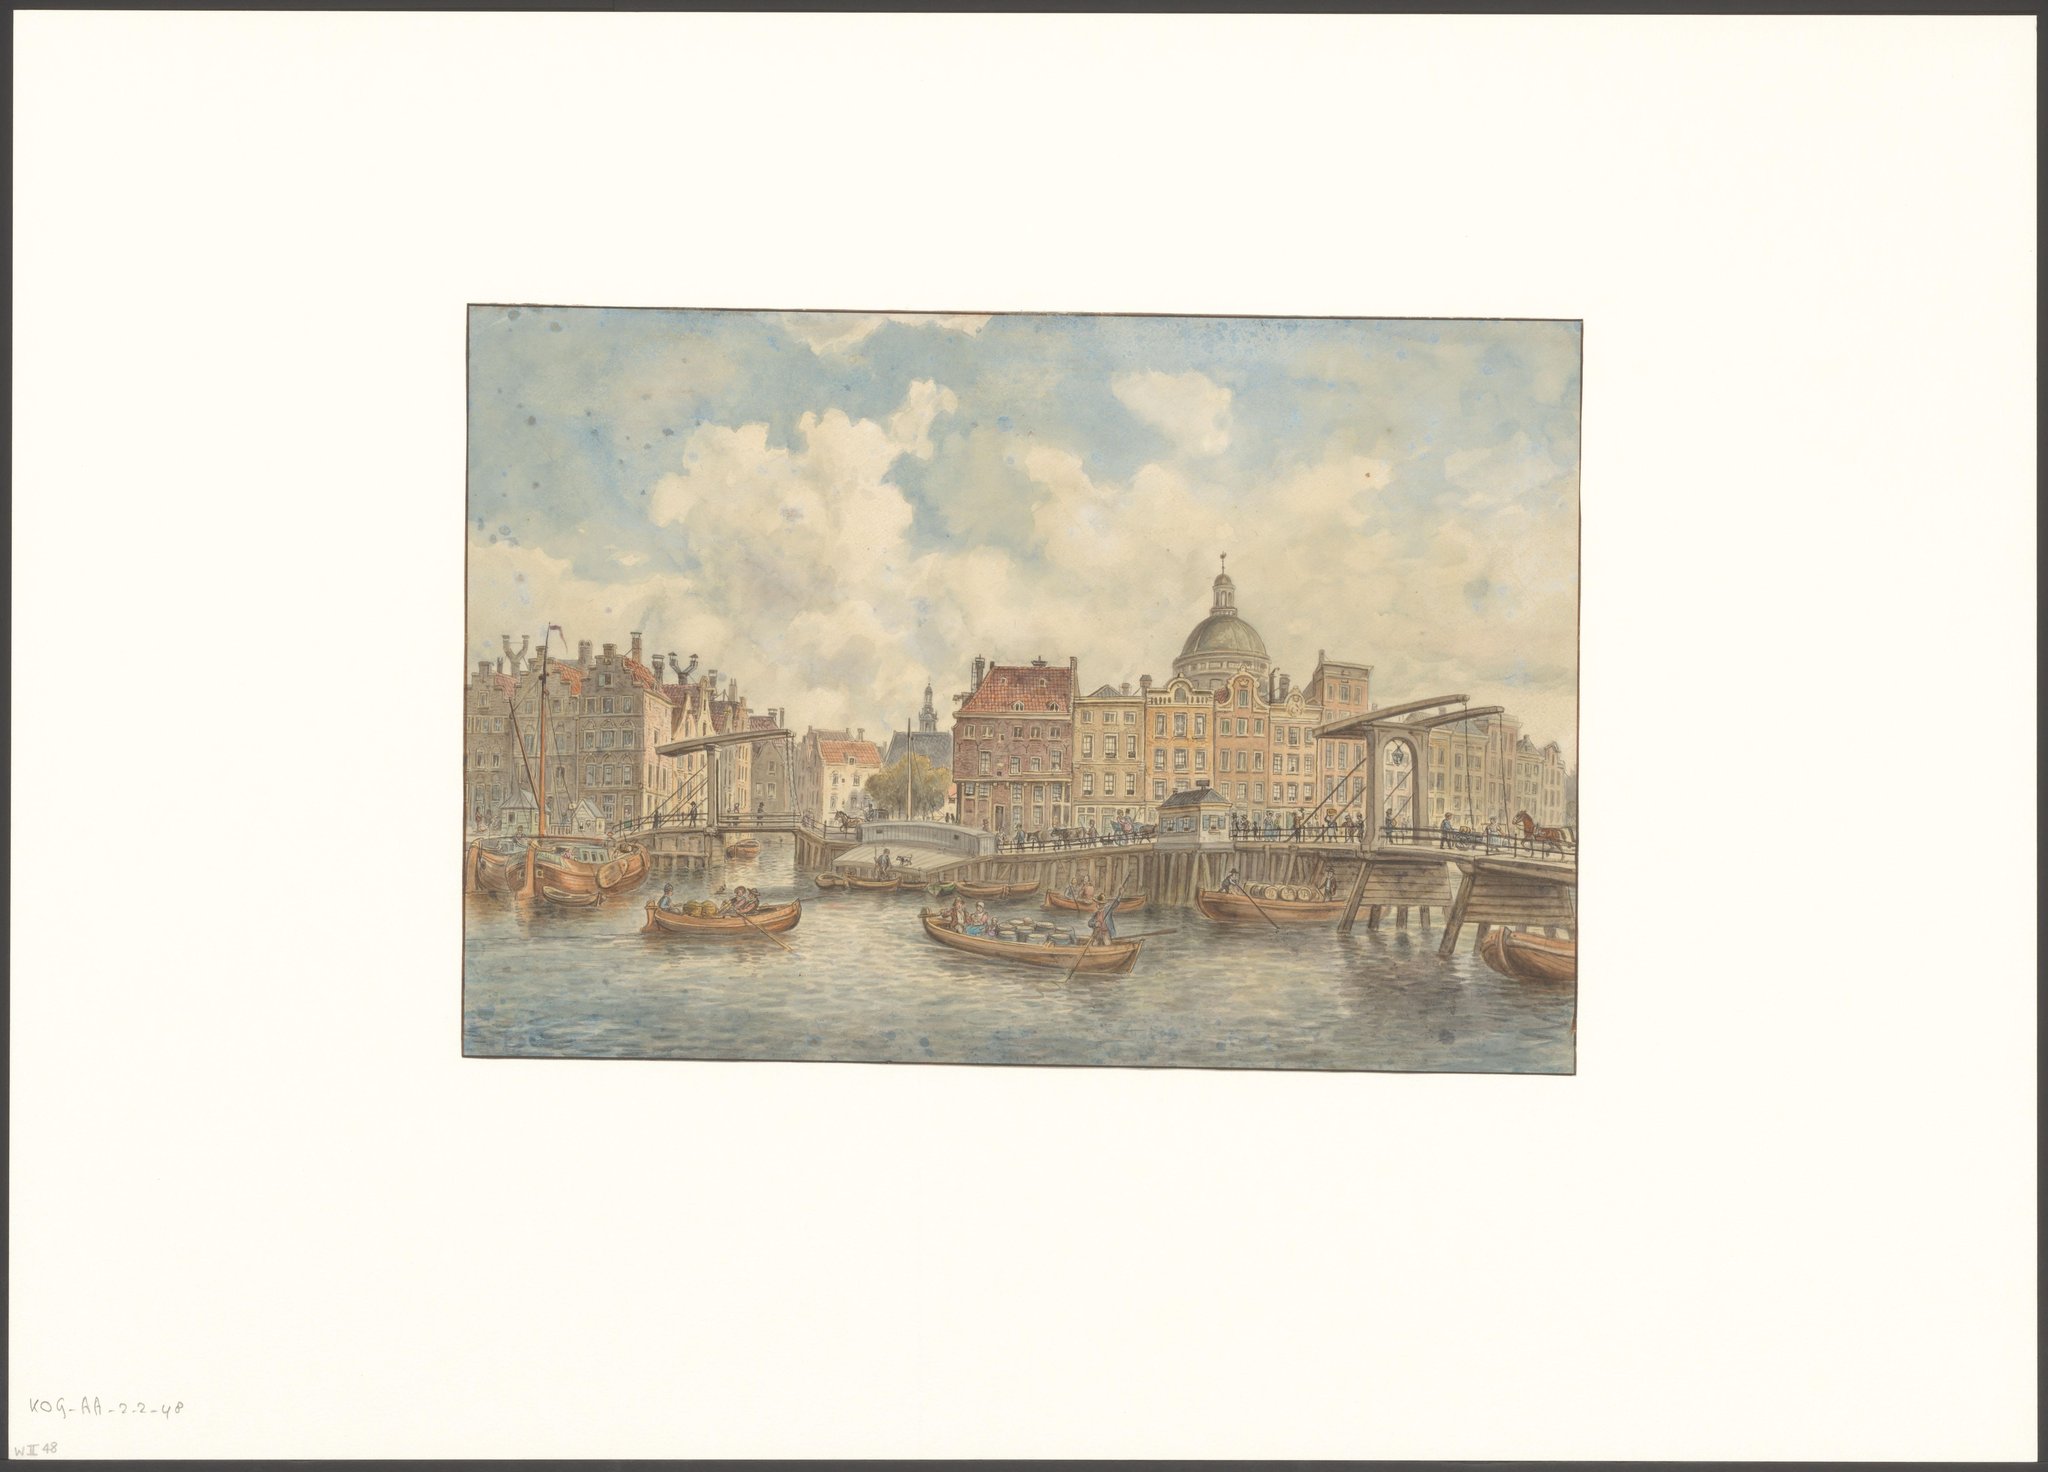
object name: drawing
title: Gezicht op de Haringpakkerij, hoek Martelaarsgracht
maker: johan martinus anthon rieke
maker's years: 1851-1899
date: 1861-1899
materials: ink, paper, pencil, watercolor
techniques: brush, pen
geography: amsterdam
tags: city-view in general; 'veduta', canal, bridge in city across river, canal, etc., boat propelled by man or animal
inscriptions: inscription: ‘Haringpakkerij’, collector's mark: Lugt 800a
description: Tekening binnen de Atlas Van Eck ingedeeld op wijknummer 2.